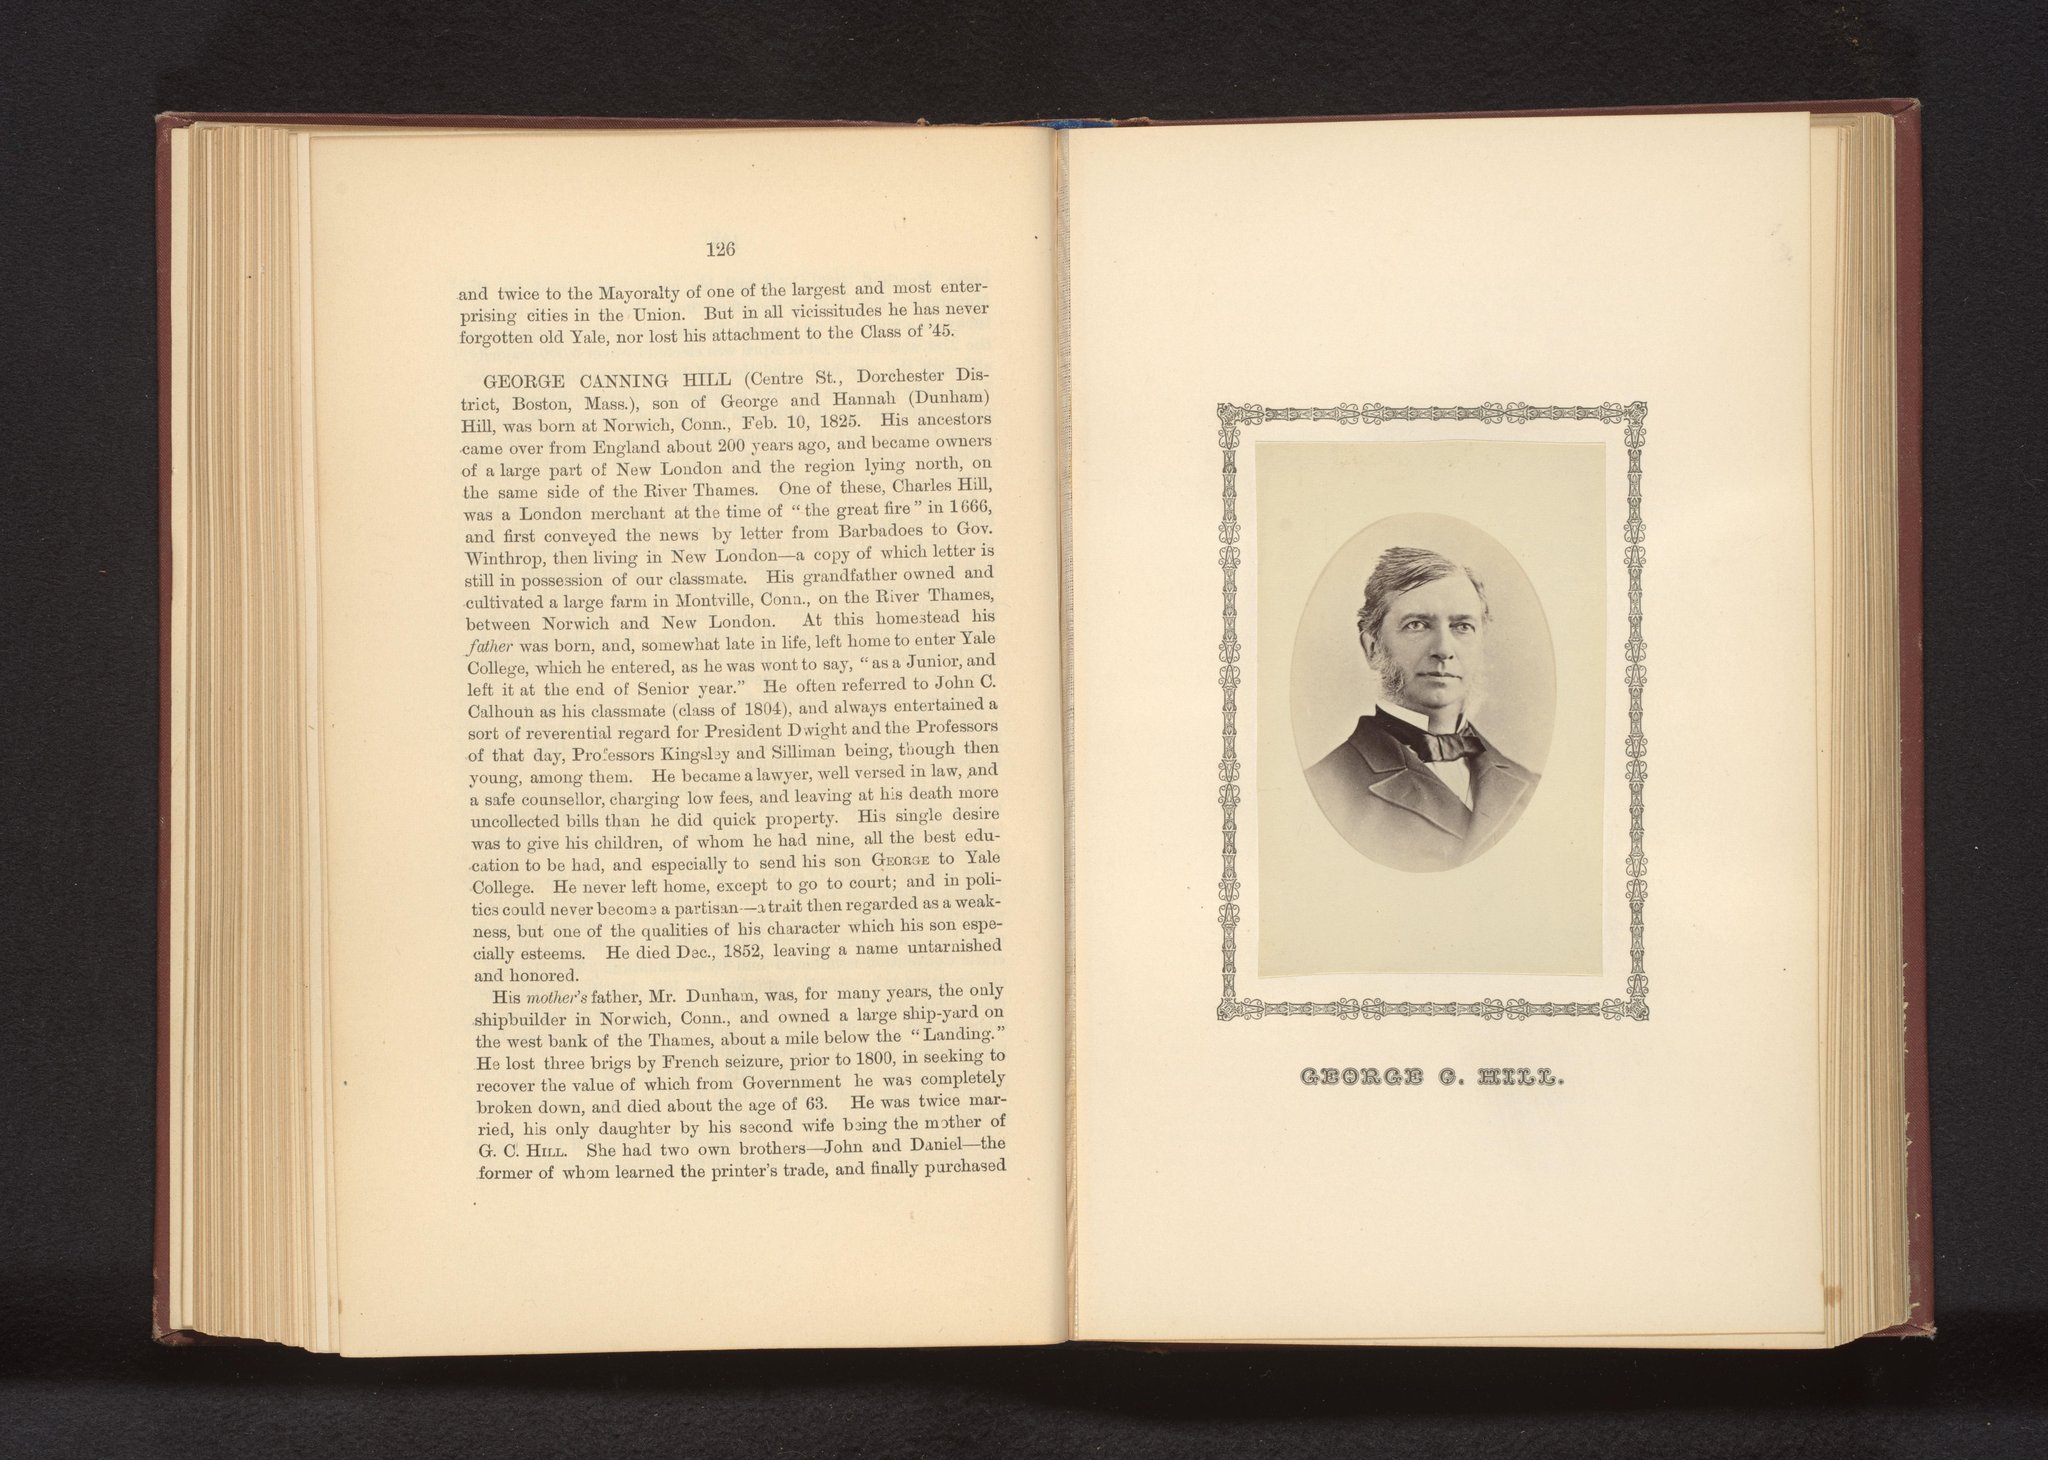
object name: page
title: George C. Hill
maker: Anonymous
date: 1876-1881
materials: photographic support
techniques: albumen print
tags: politician, adult man